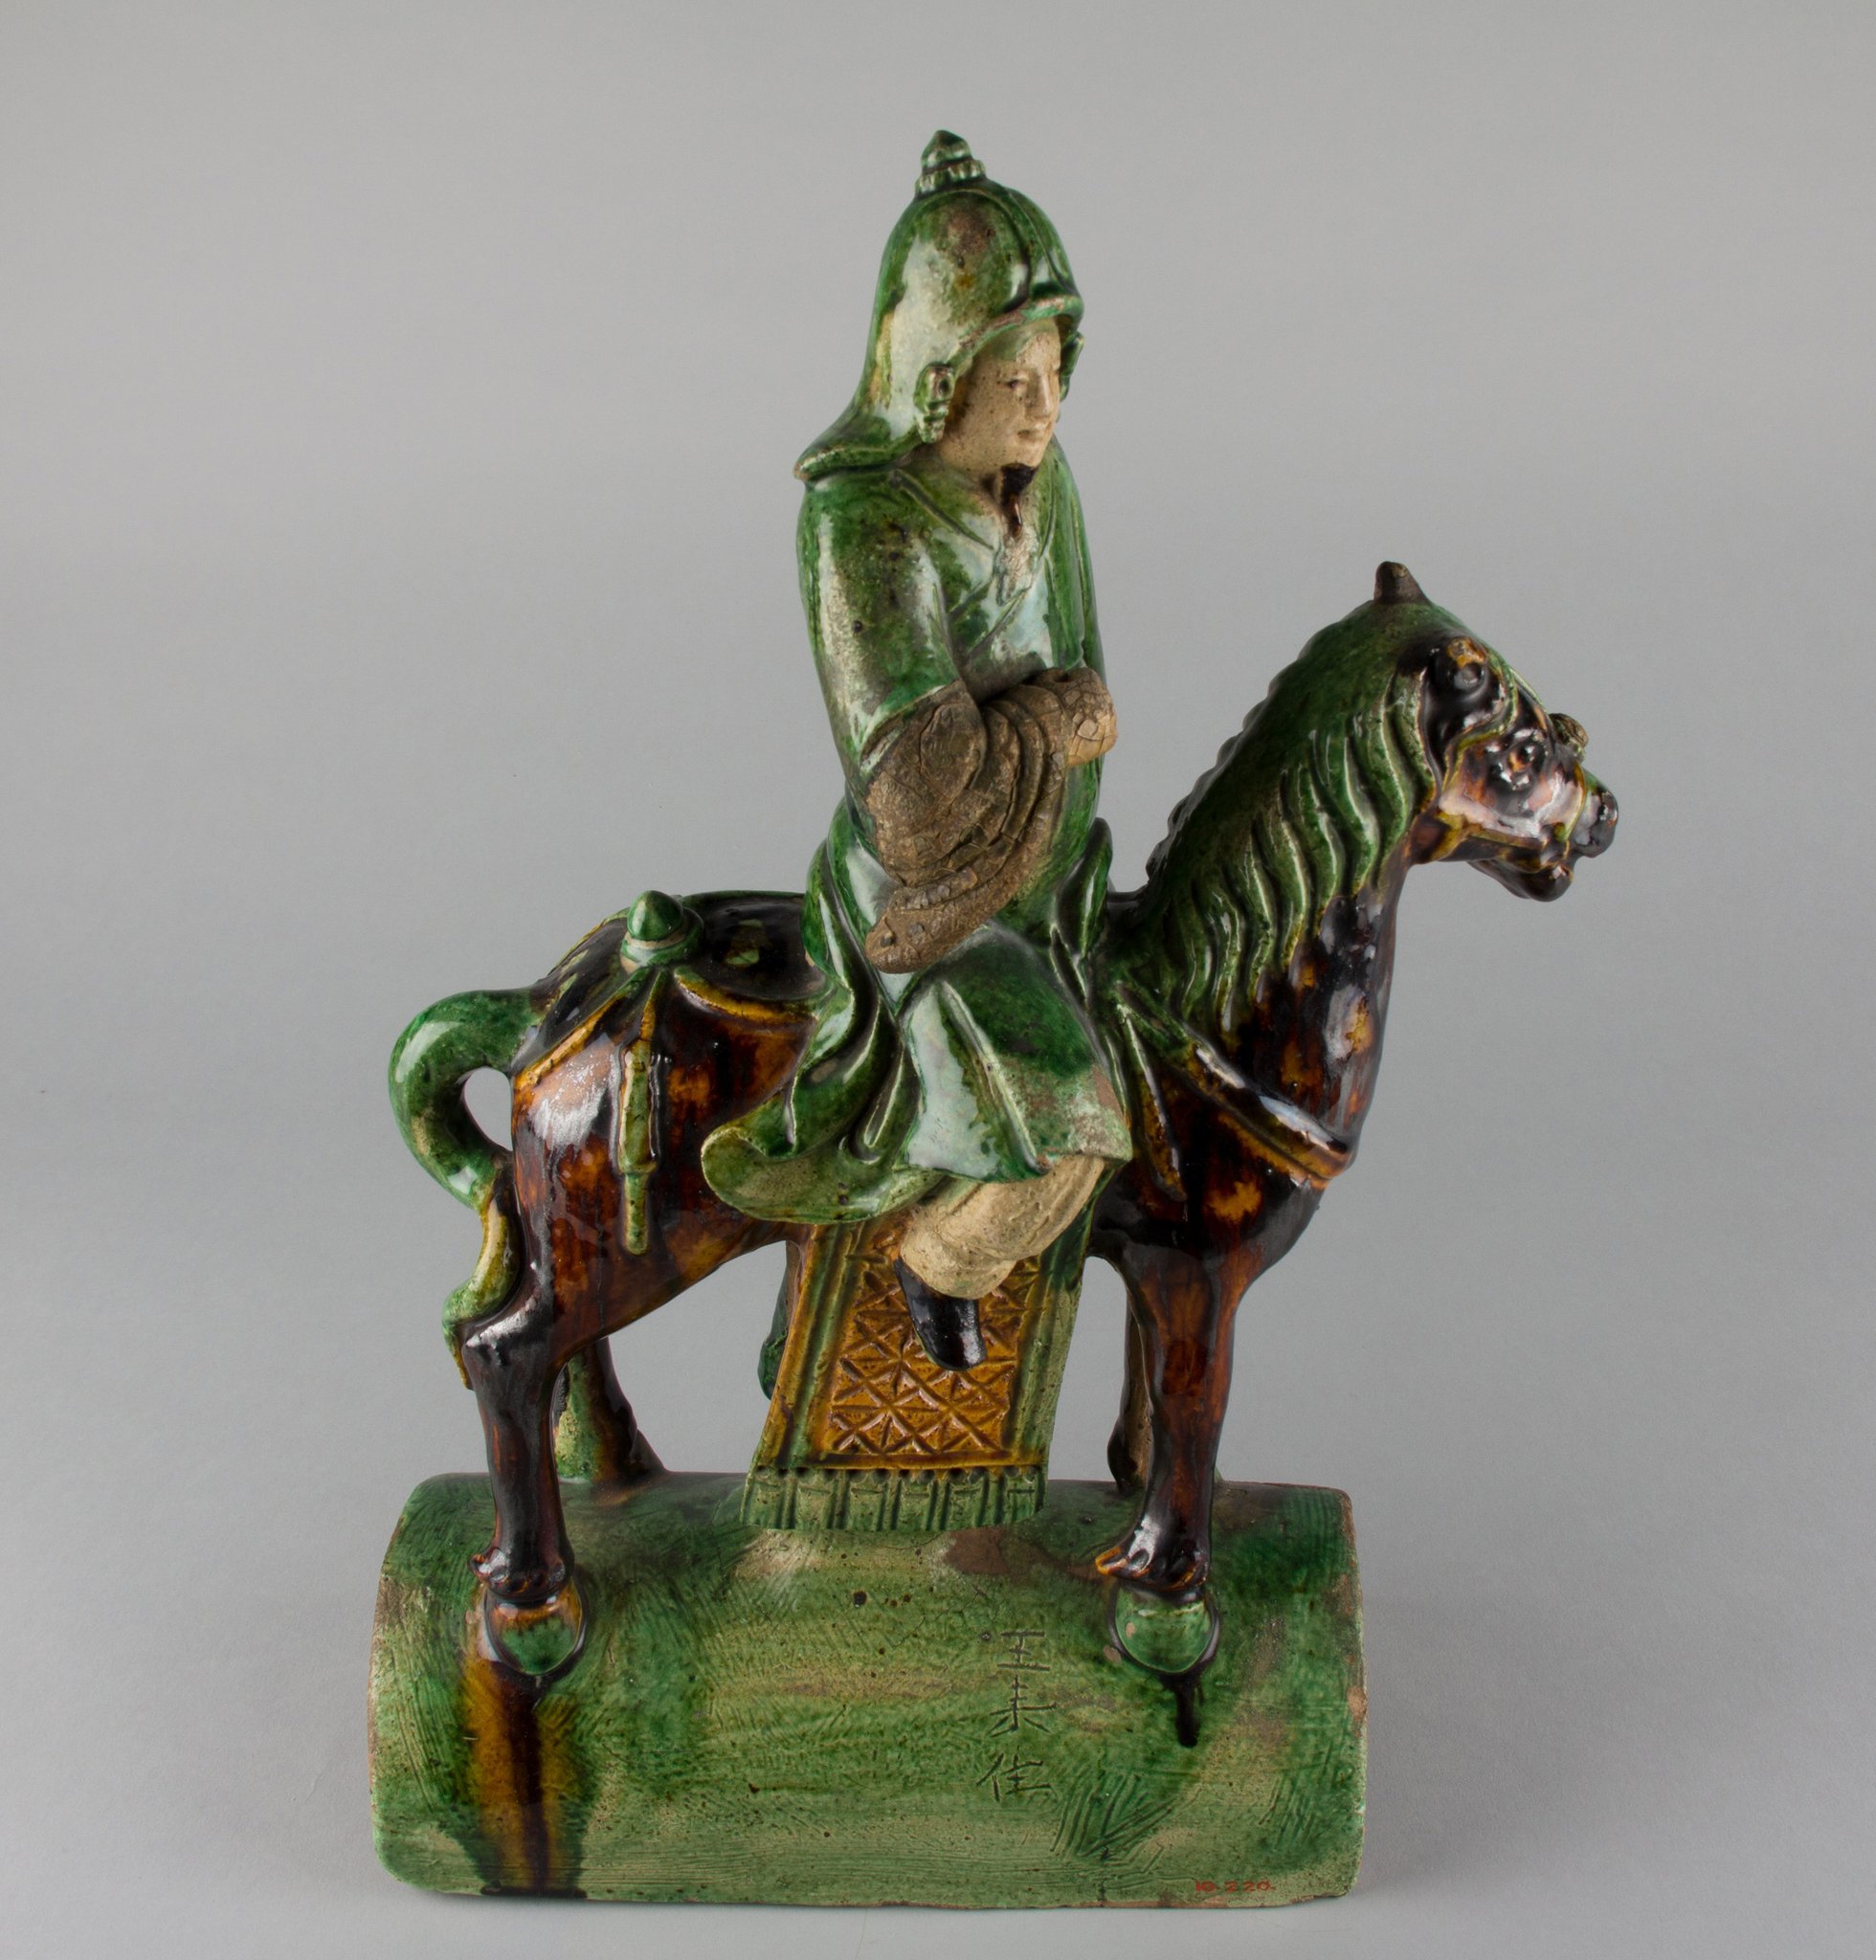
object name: tile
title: Roof Tile in Form of a Mounted Warrier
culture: chinese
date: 1368-1644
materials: pottery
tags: men,horses